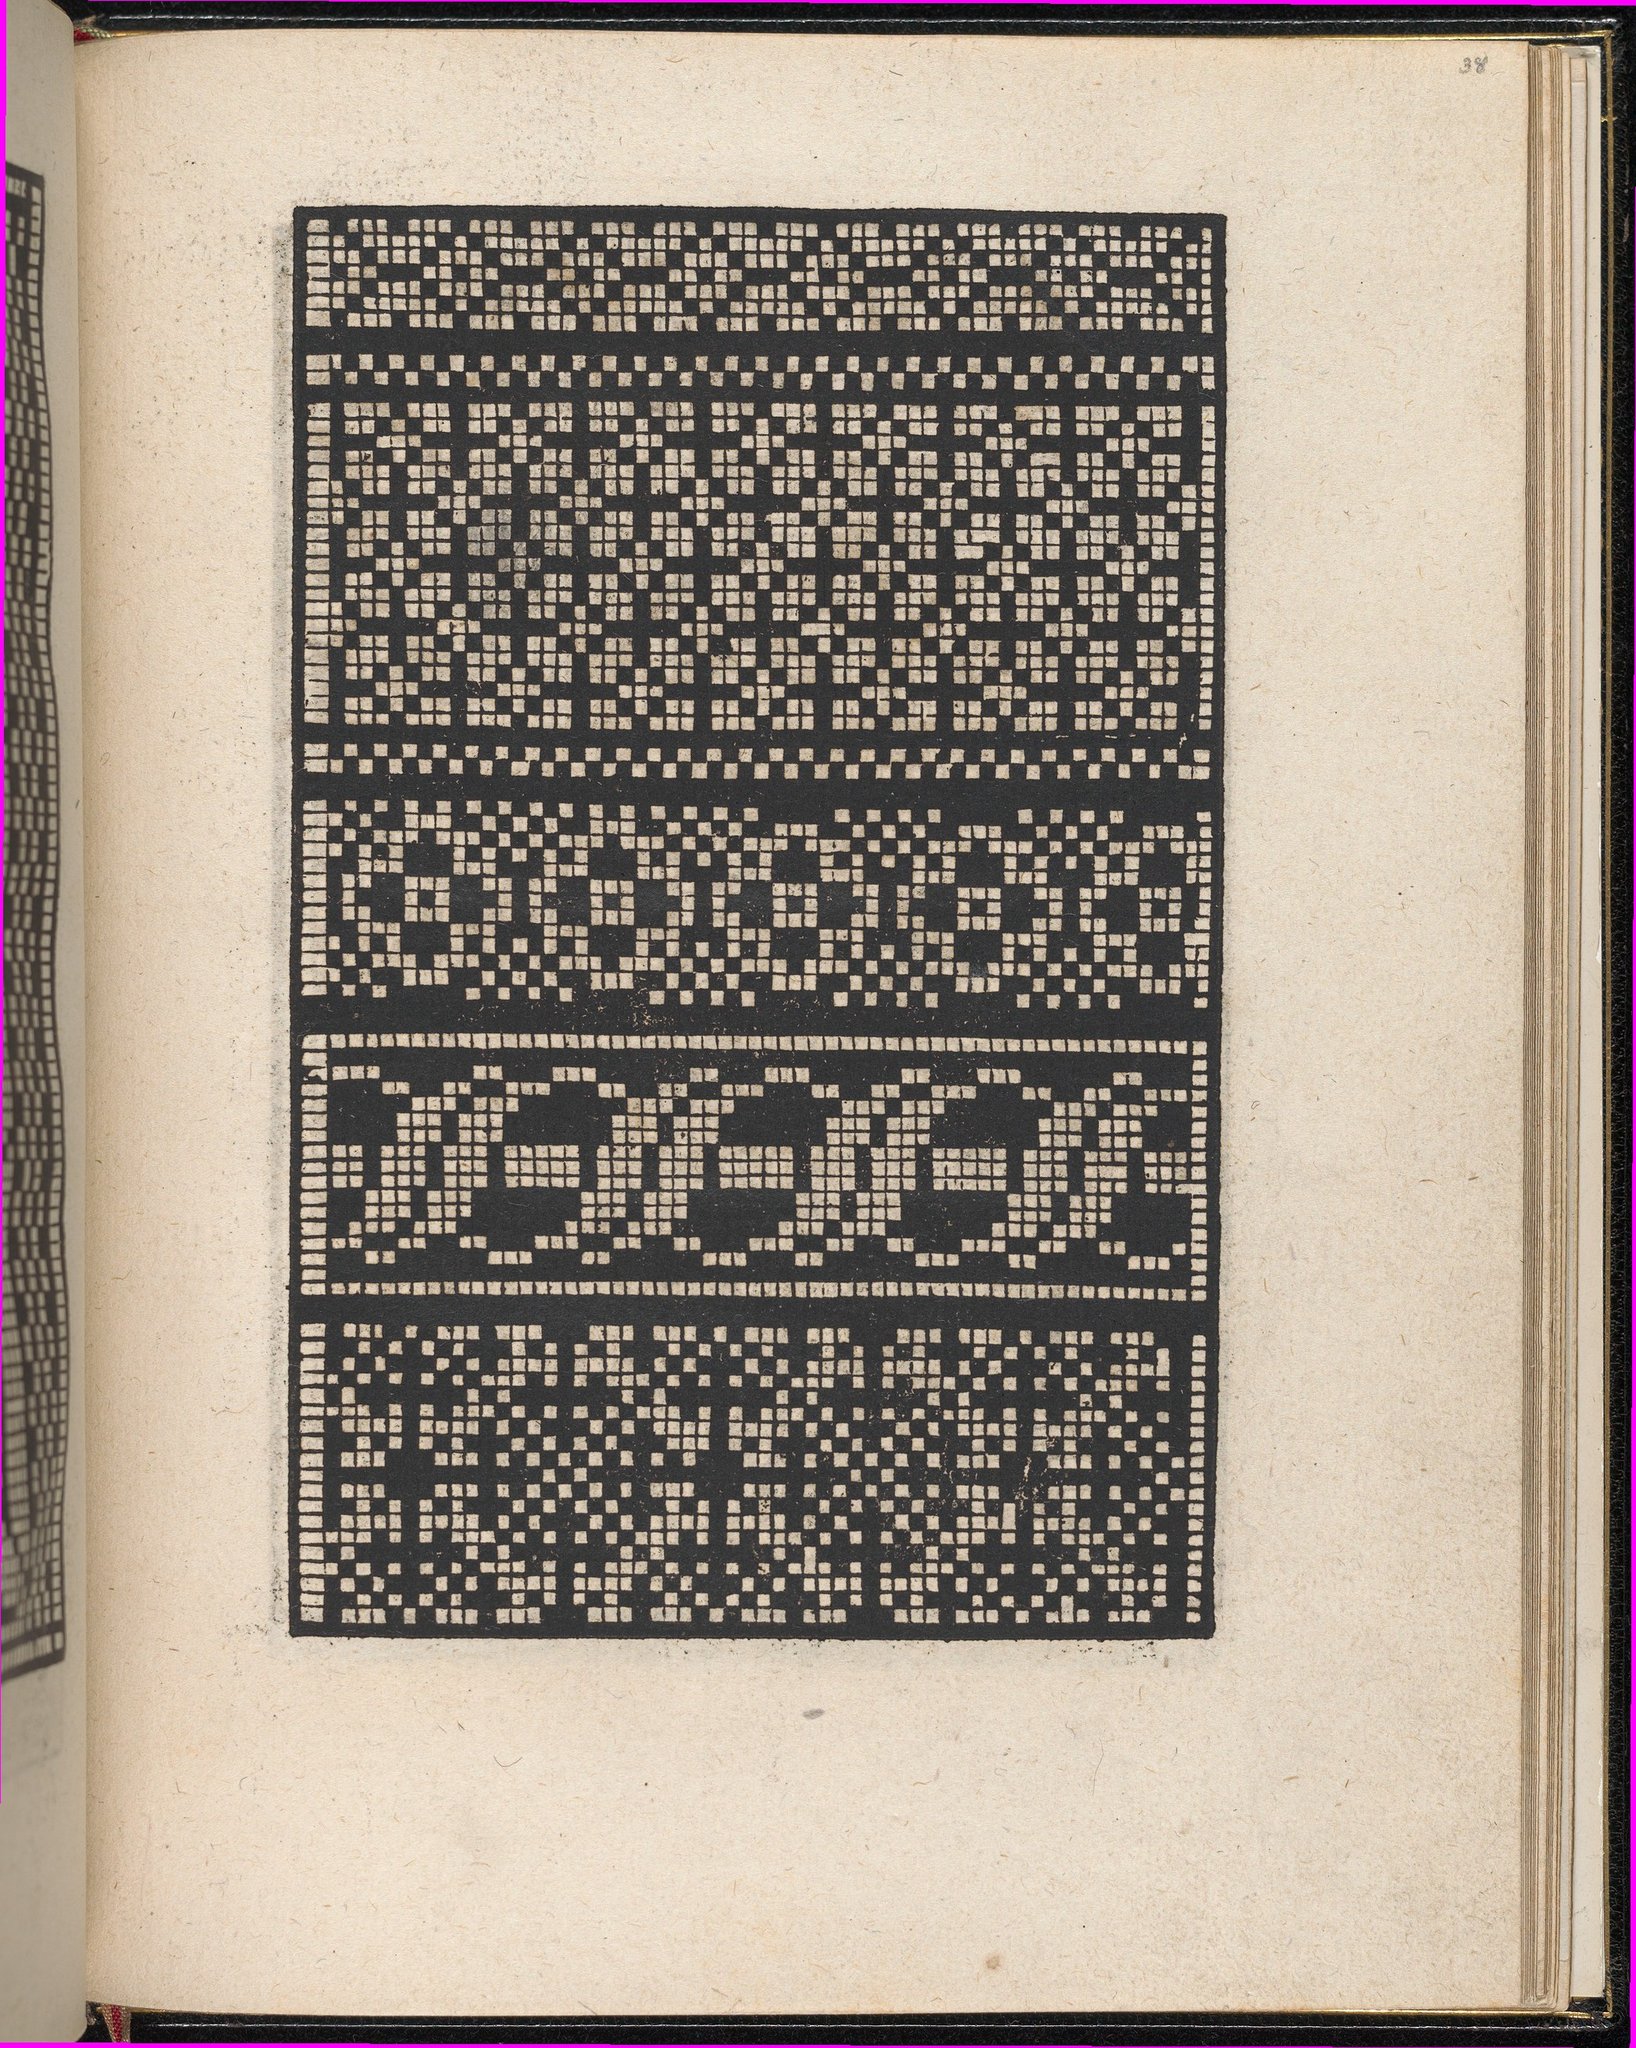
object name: book print ornament architecture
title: Page from Ein new kunstlich Modelbuch...(Page 38r)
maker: peter quentel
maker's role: publisher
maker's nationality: german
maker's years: 1500-1550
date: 1544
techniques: woodcut